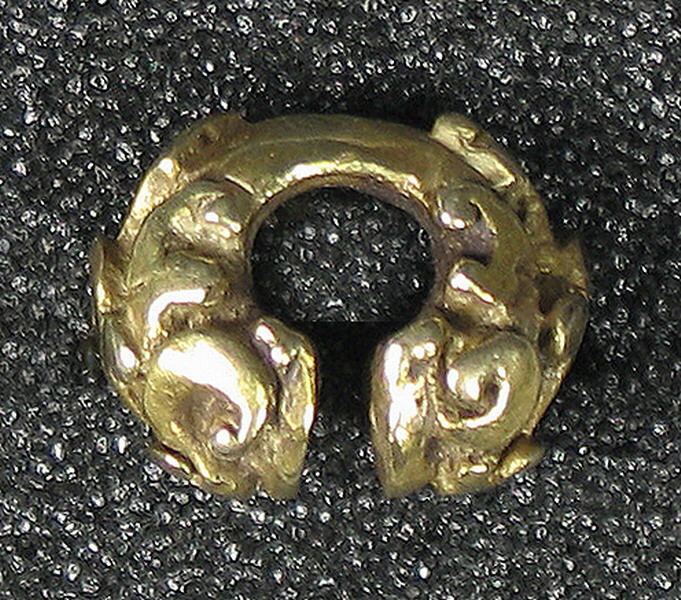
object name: earring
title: Earring with Foliate Decoration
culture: indonesian, central java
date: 701-1200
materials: gold